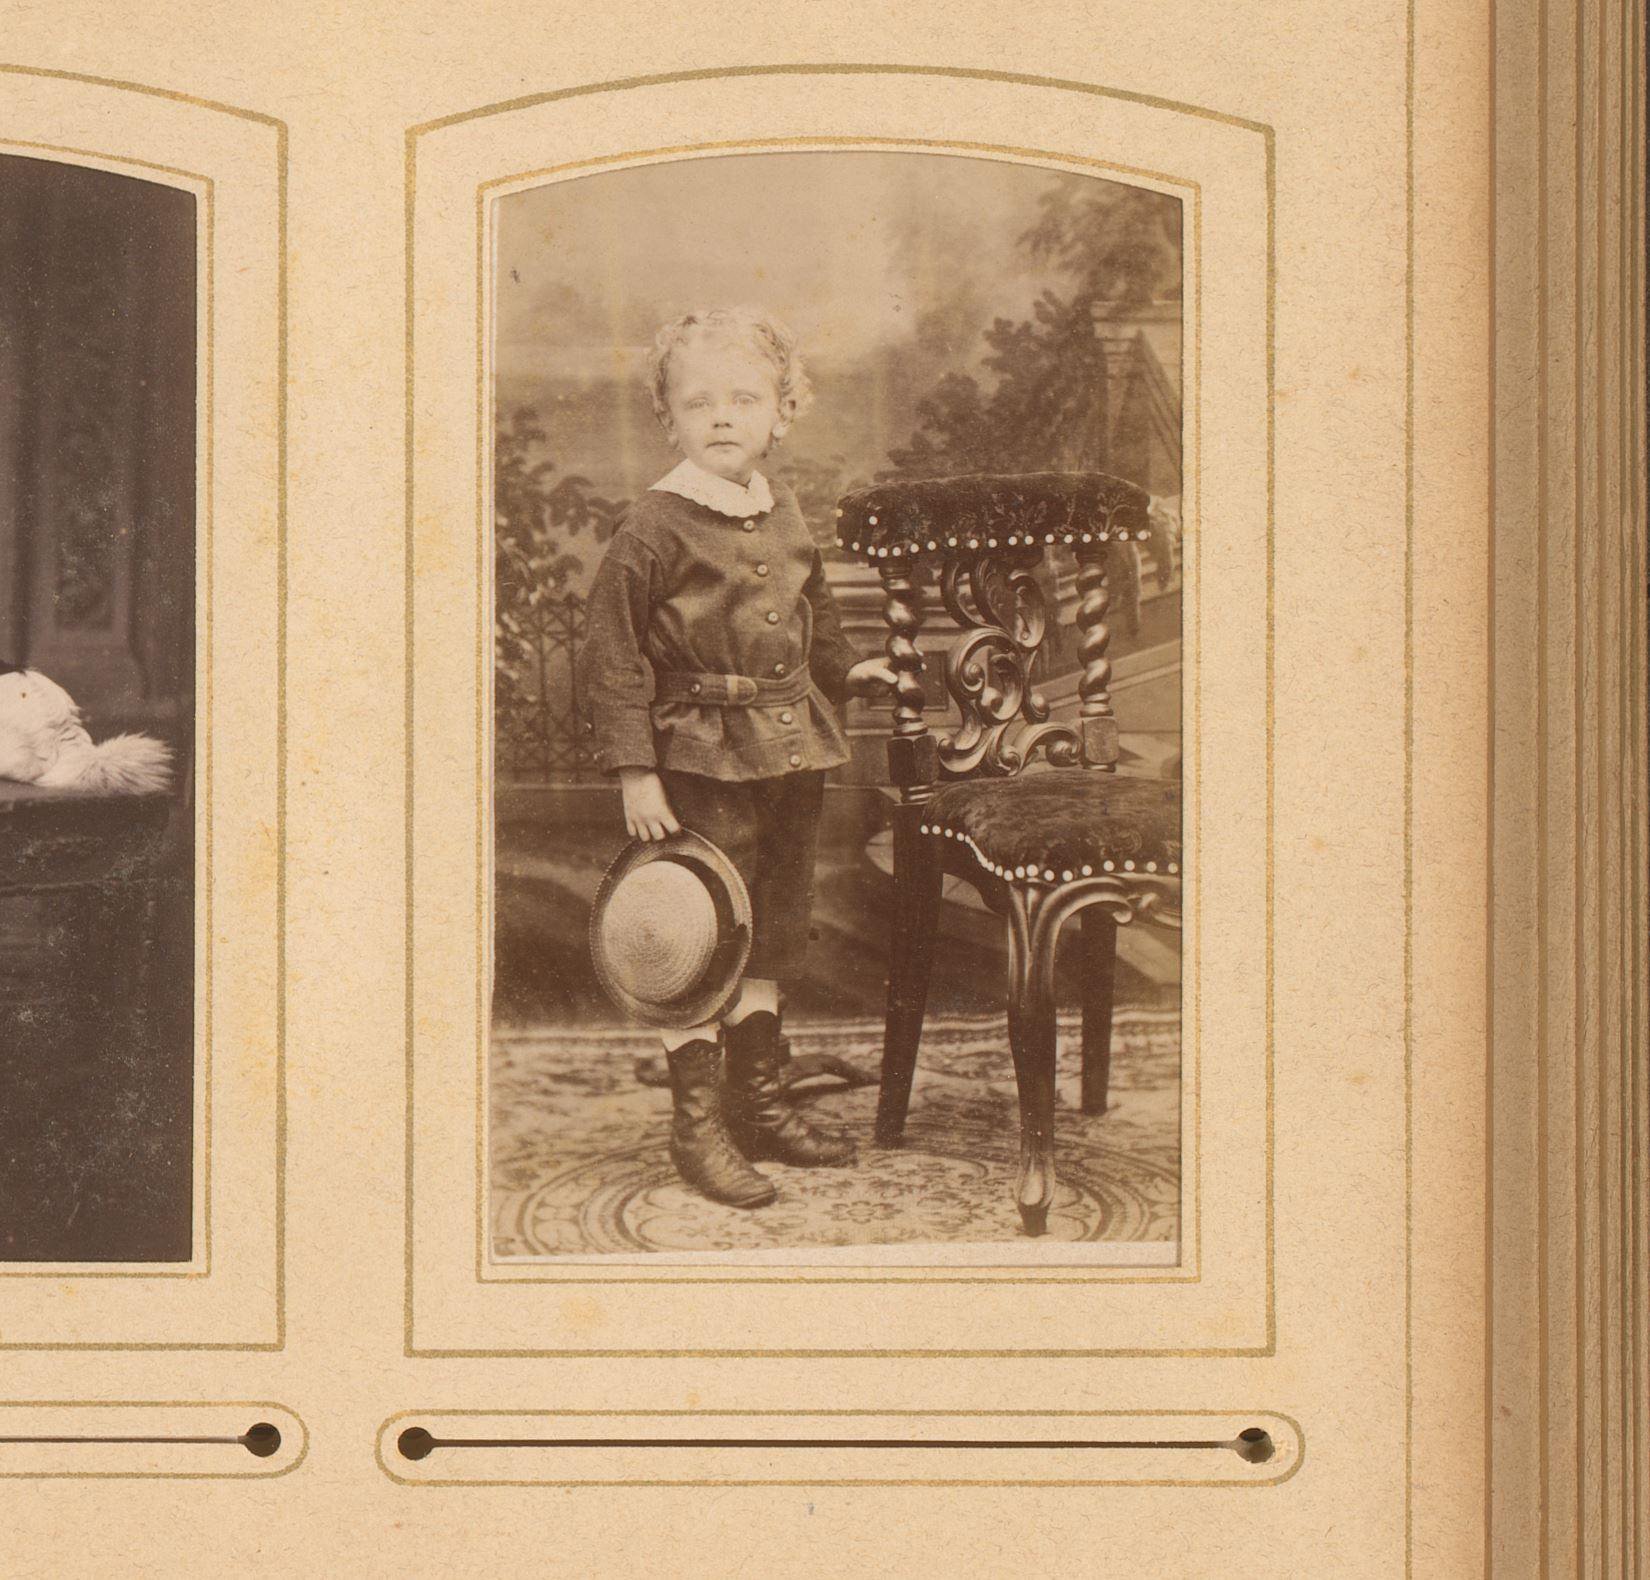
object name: photograph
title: Portret van een jongen met hoed in de hand, staand bij een stoel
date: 1857-1898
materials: cardboard, photographic support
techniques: albumen print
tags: boy (child between toddler and youth), historical persons, head-gear: hat, chair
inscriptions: inscription: ‘P. SIEWERS en ZOON/ Photograph:/ ATELIER/ EDAM/ Voorhaven/ HILVERSUM/ Badhuis./ Te Edam dagelyks werkzaam./ Te Hilversum Zondags en maandags/ De Plaat word voor Nabestelling/ bewaard.’